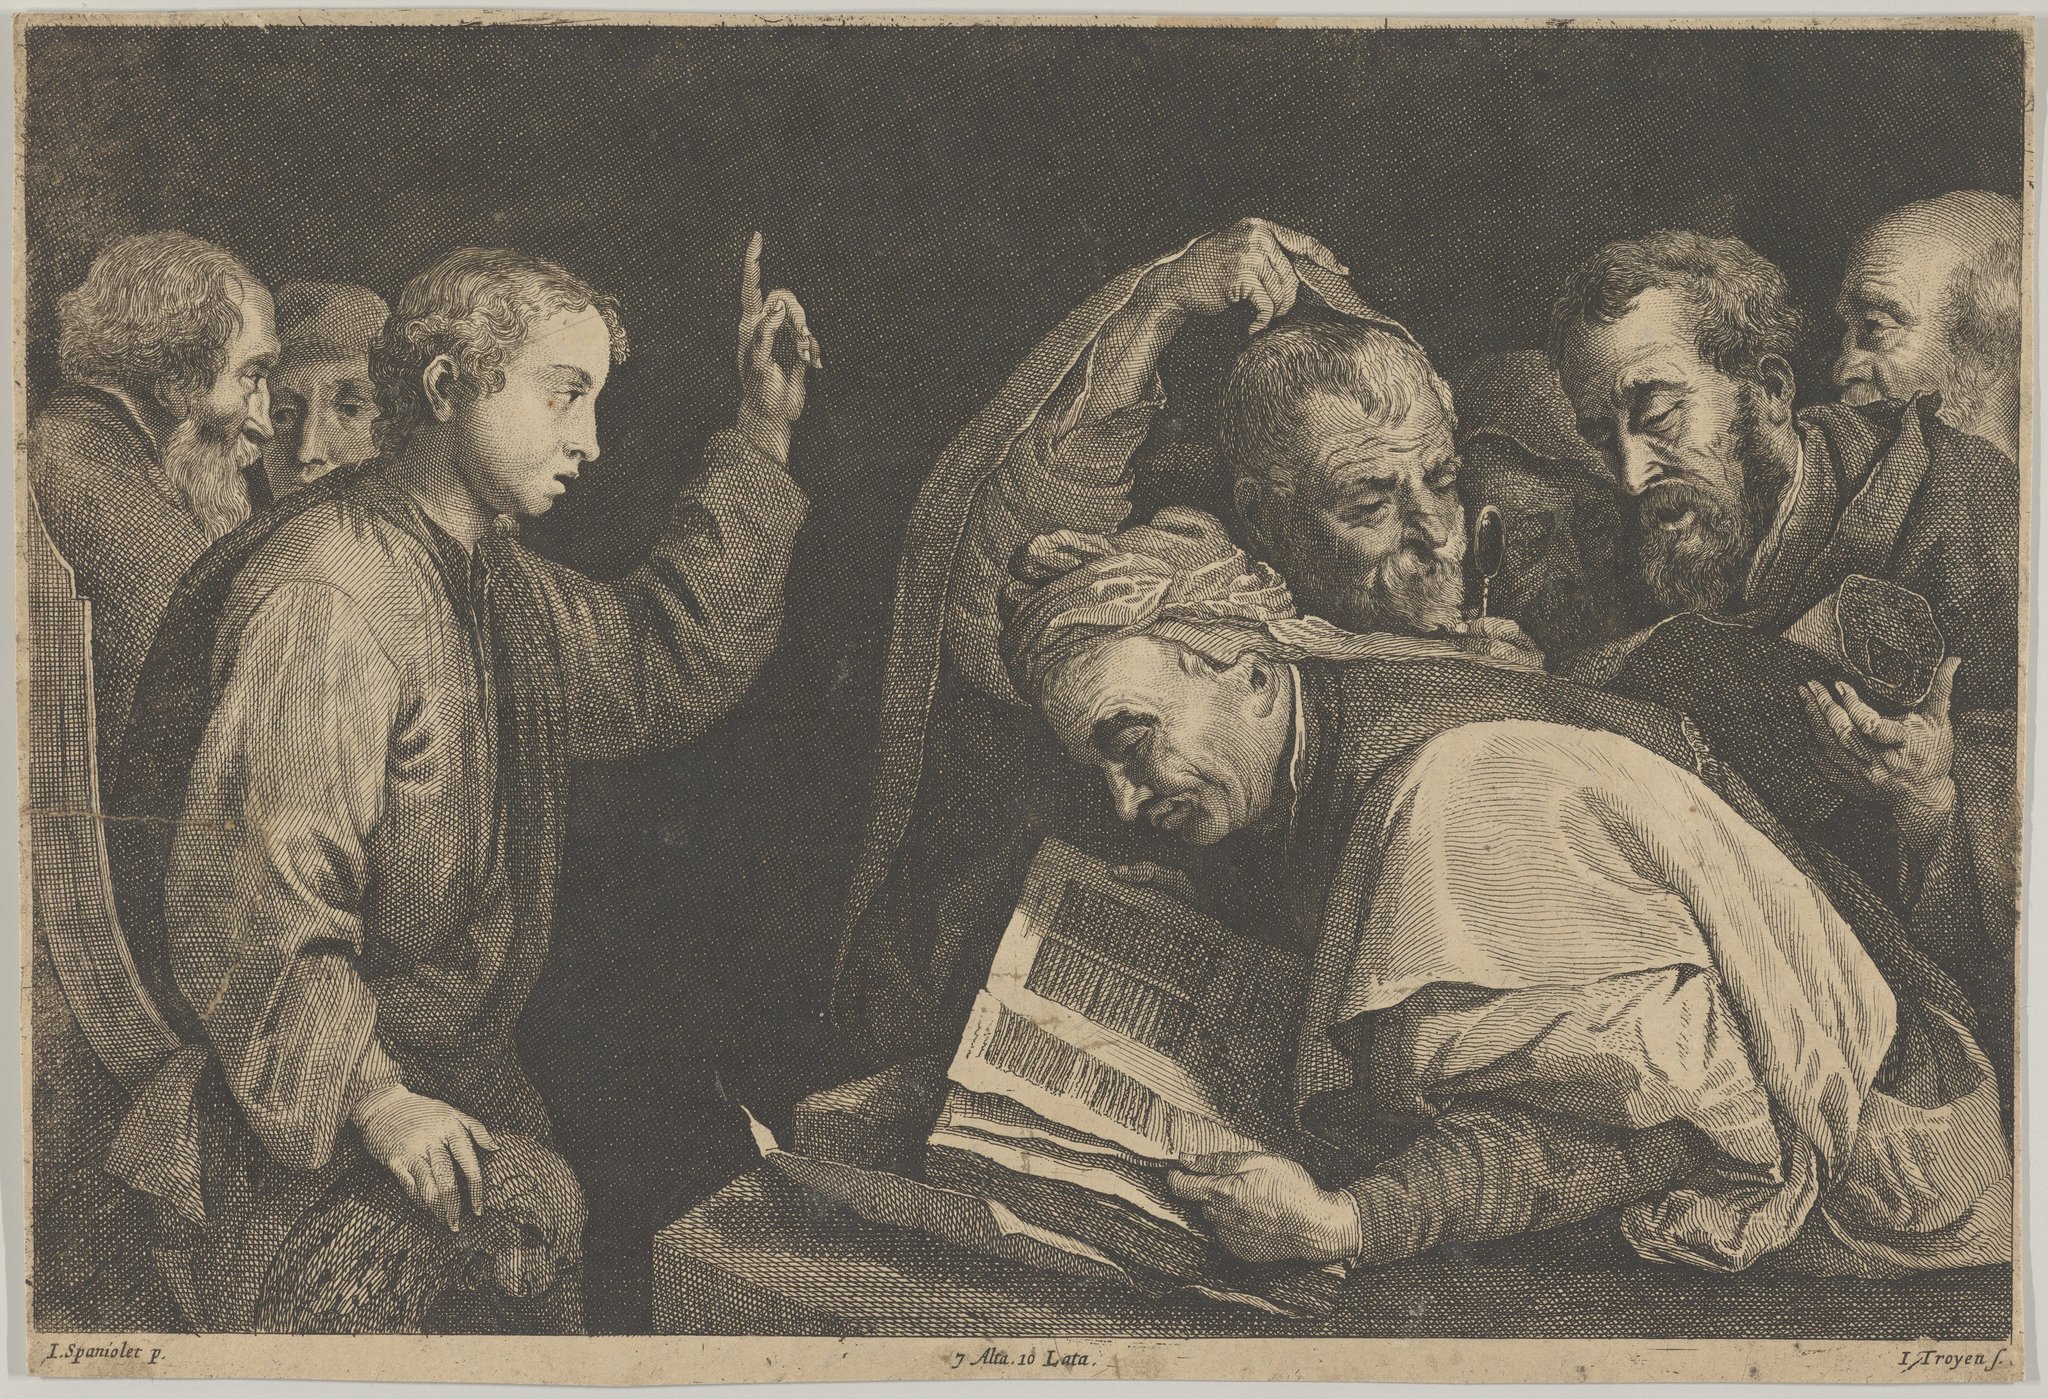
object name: print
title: Young Christ Among the Doctors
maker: jan van troyen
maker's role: artist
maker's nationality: flemish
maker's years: 1610-1666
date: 1656-1660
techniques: etching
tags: books,men,reading,christ,doctors